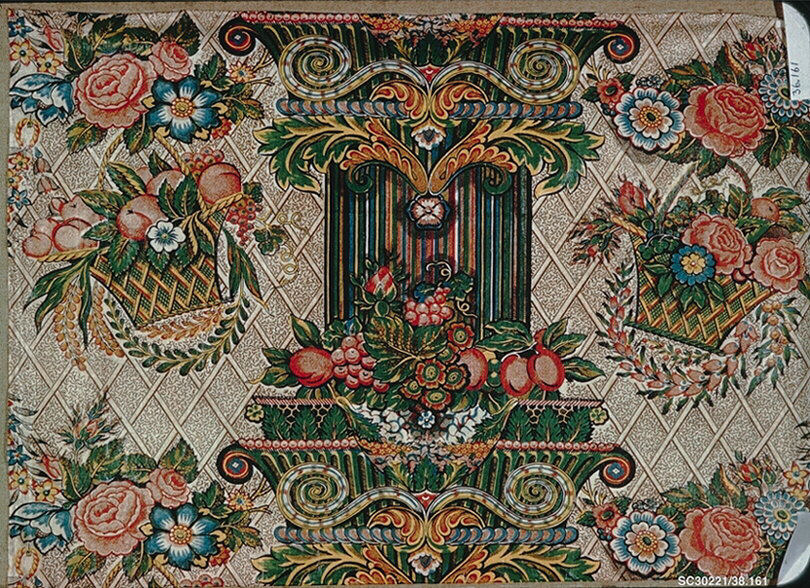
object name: piece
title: Pillar print textile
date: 1830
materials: cotton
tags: columns,fruit,flowers